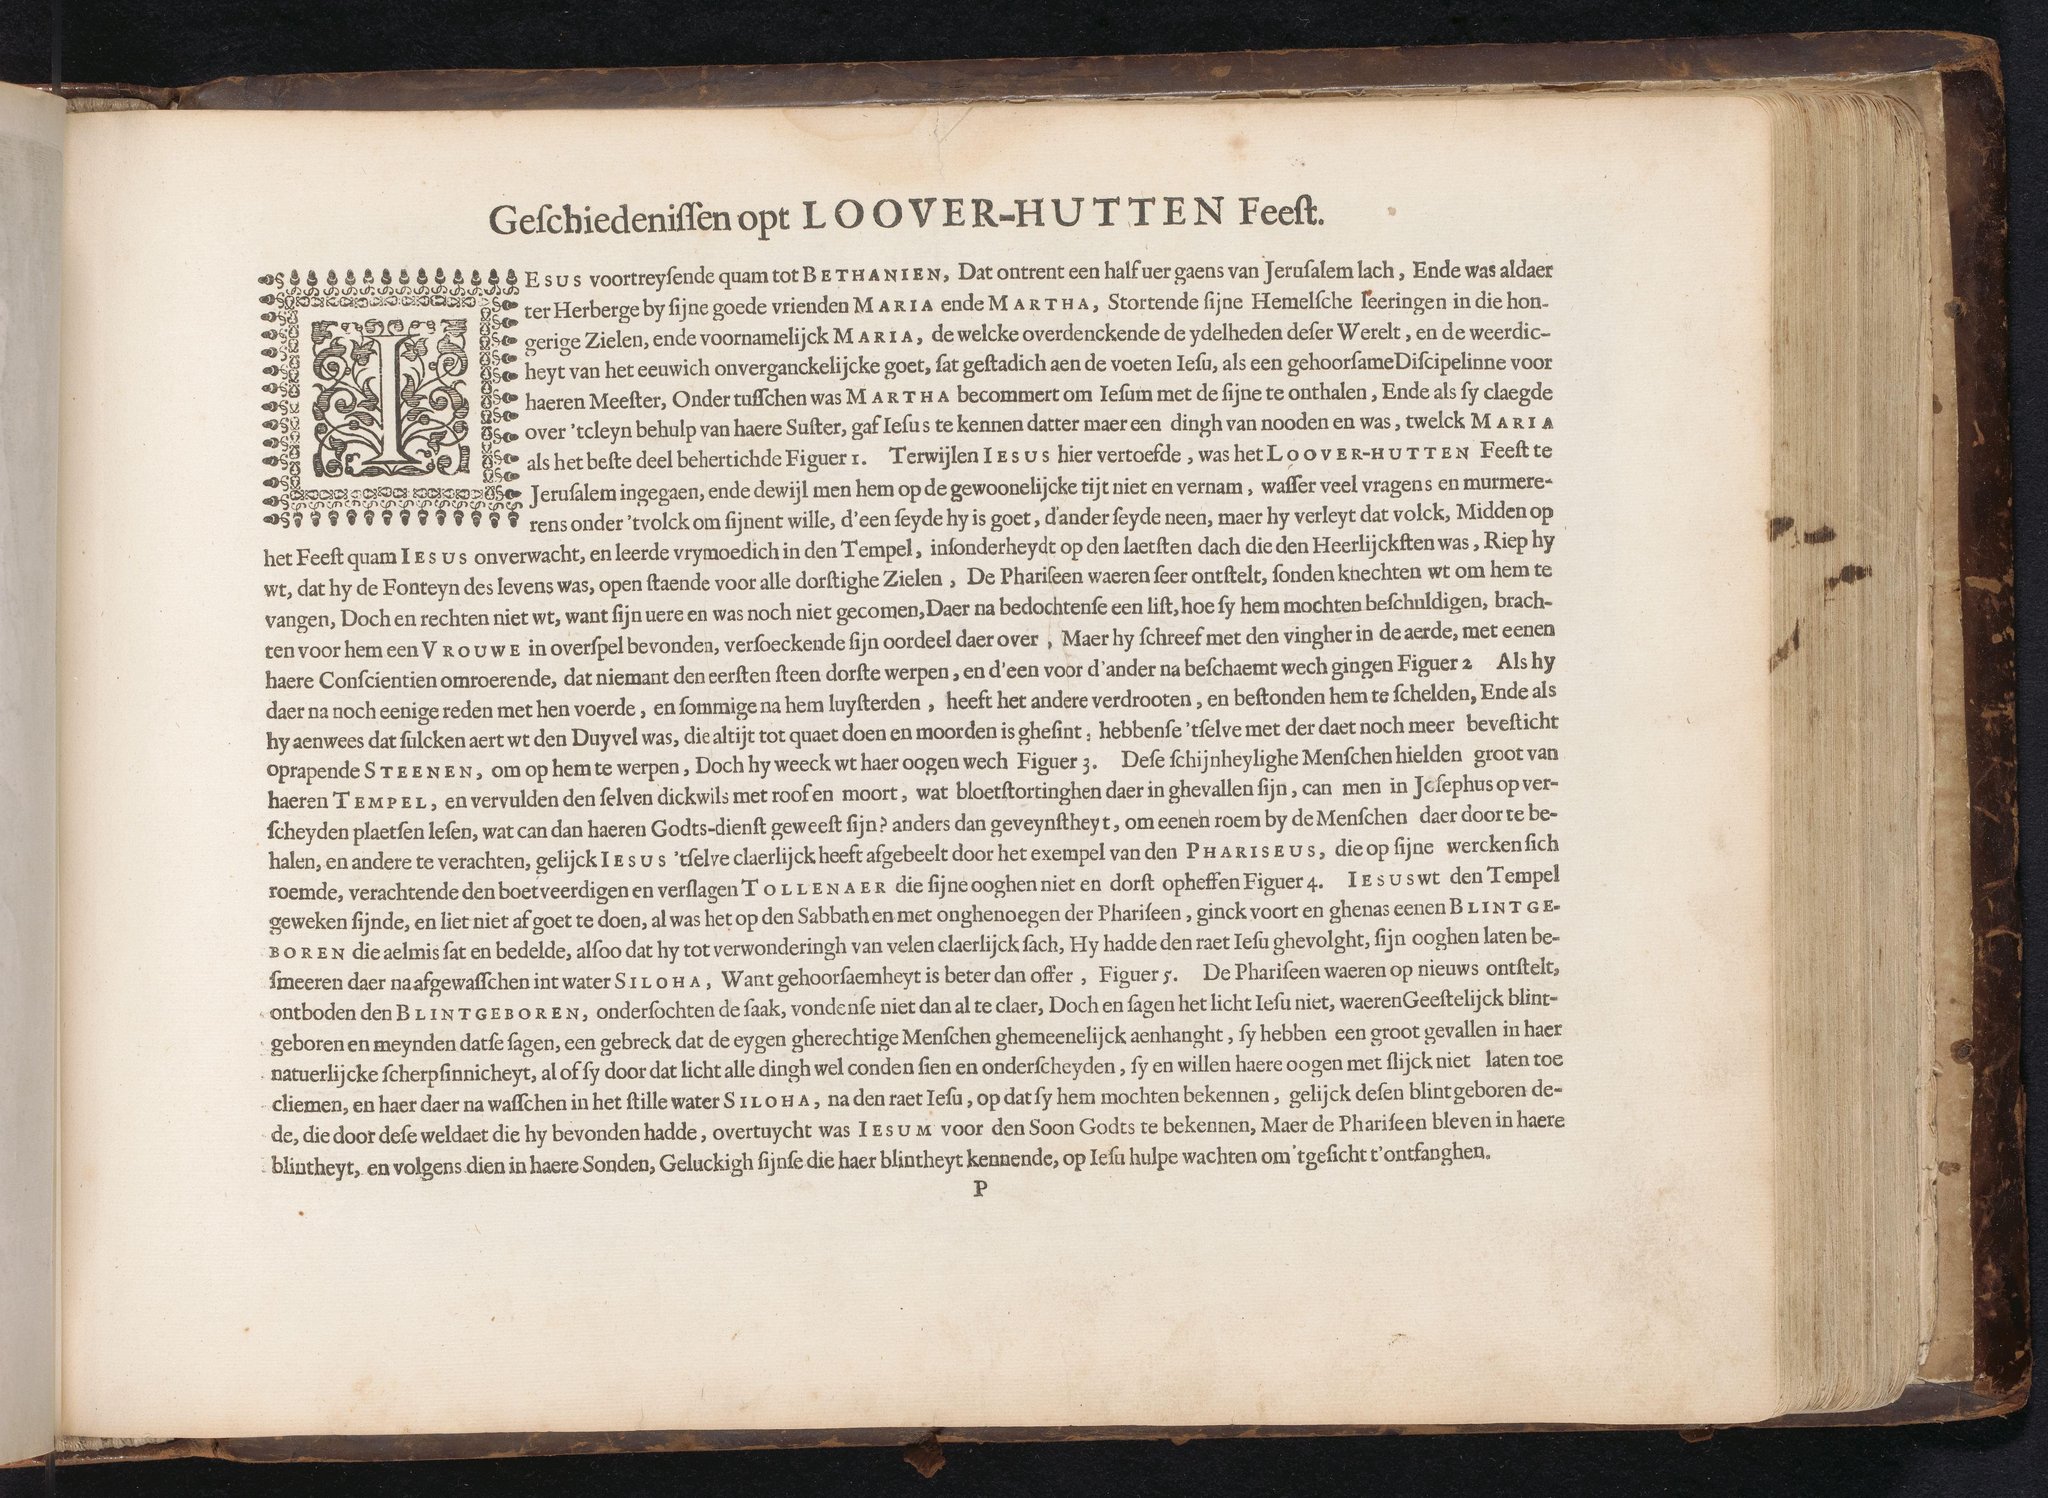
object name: album leaf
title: Den Grooten Figuer-Bibel (...)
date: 1646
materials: paper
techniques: letterpress printing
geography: alkmaar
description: Tekstblad bij een serie prenten over Christus op het Loofhuttenfeest. Linksboven initiaal I. Dit blad maakt deel uit van een album.